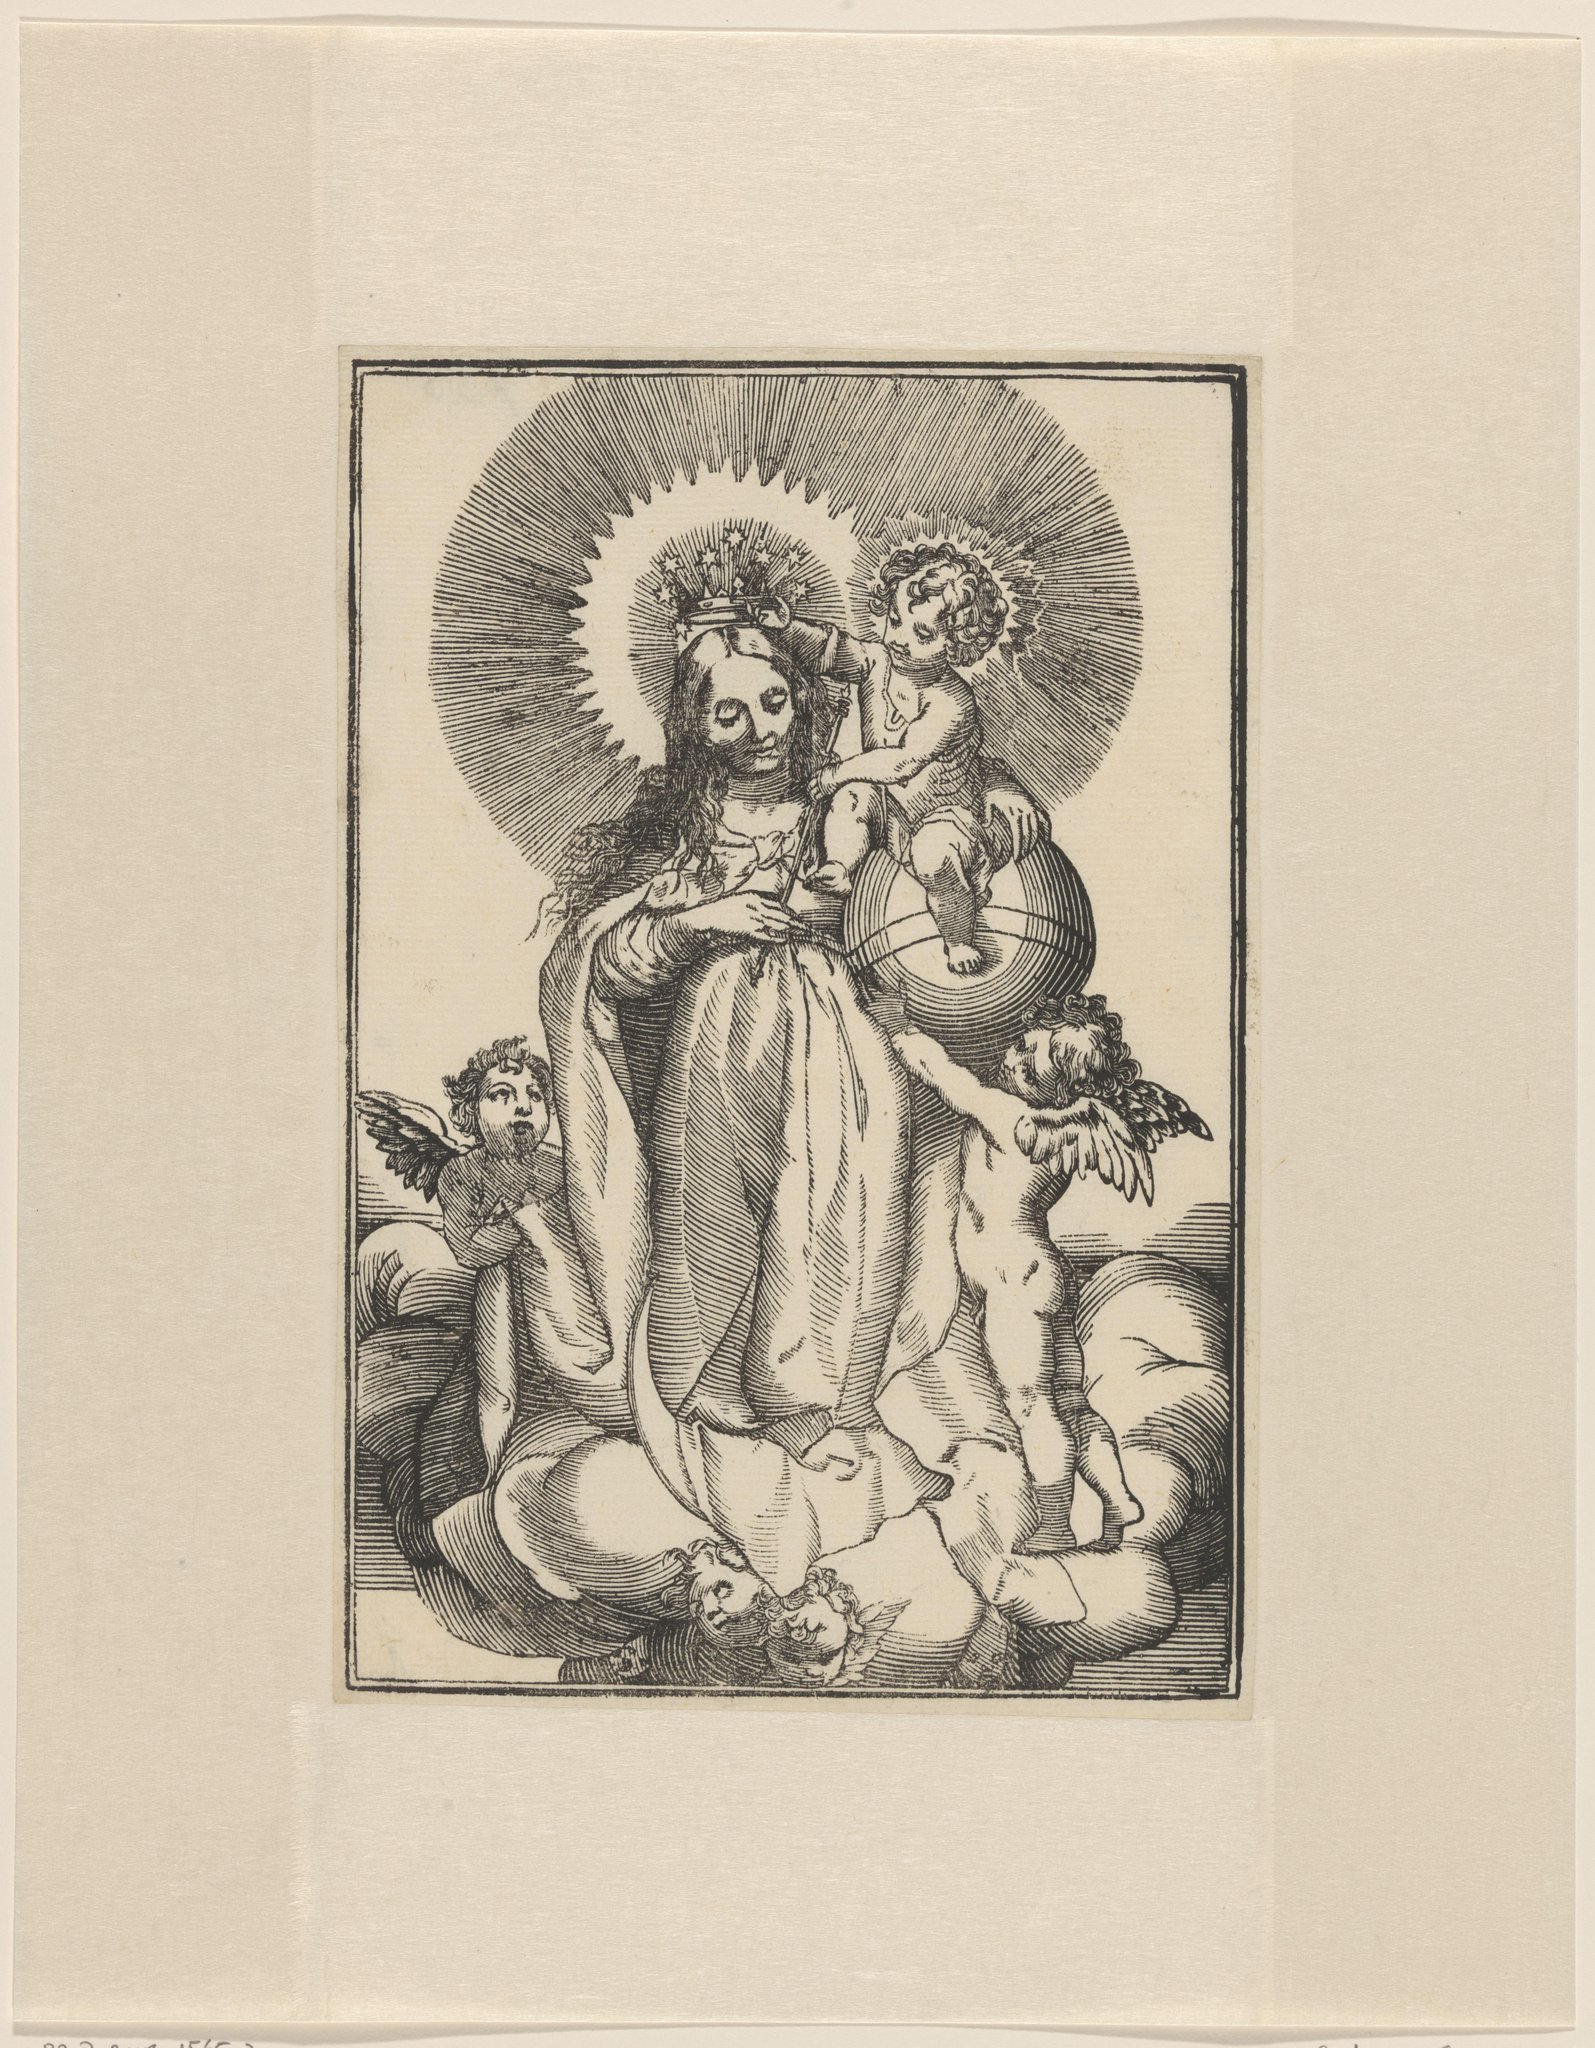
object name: print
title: De hemelvaart en kroning van Maria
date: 1560-1580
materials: paper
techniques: woodcut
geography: venice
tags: madonna: mary standing (or half-length), christ-child close to her bosom, assumption of mary combined with her coronation, the christ-child crowning mary ~ madonna-representations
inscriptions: collector's mark: Lugt 2228, collector's mark: Lugt 2760